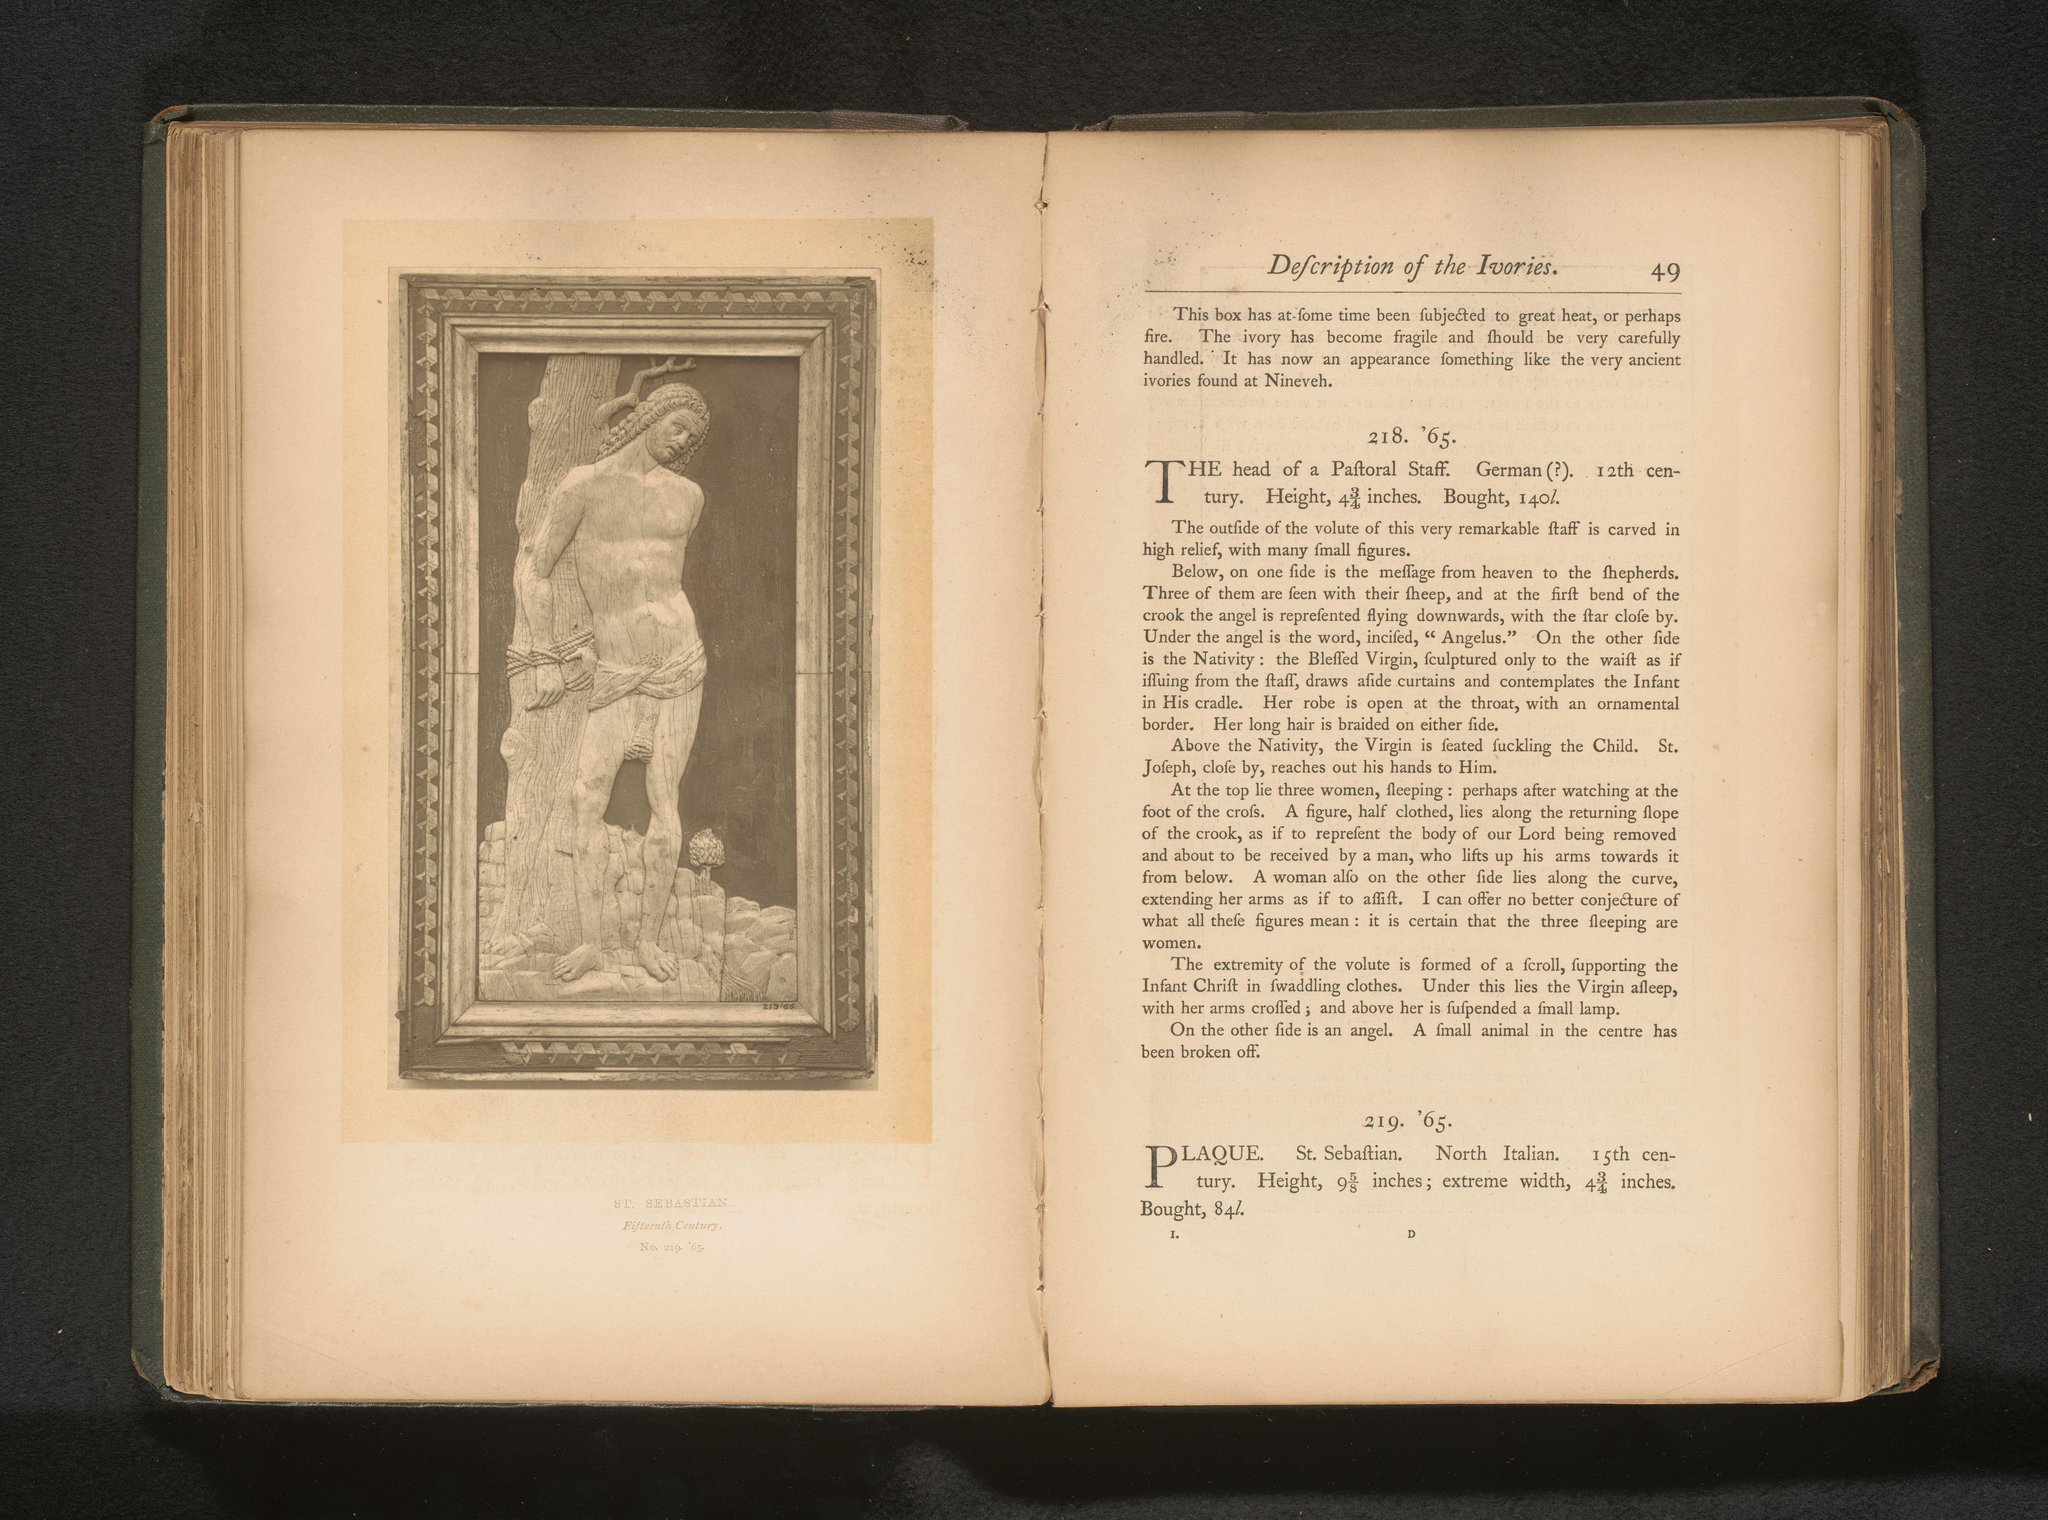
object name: page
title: St. Sebastian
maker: Anonymous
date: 1867-1872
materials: paper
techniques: woodburytype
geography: london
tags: st. sebastian, tied to a tree or a pillar, is pierced by arrows, sculpture (+ relief ~ sculpture)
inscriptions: number: ‘No. 219. '65.’, inscription: ‘Fifteenth Century.’